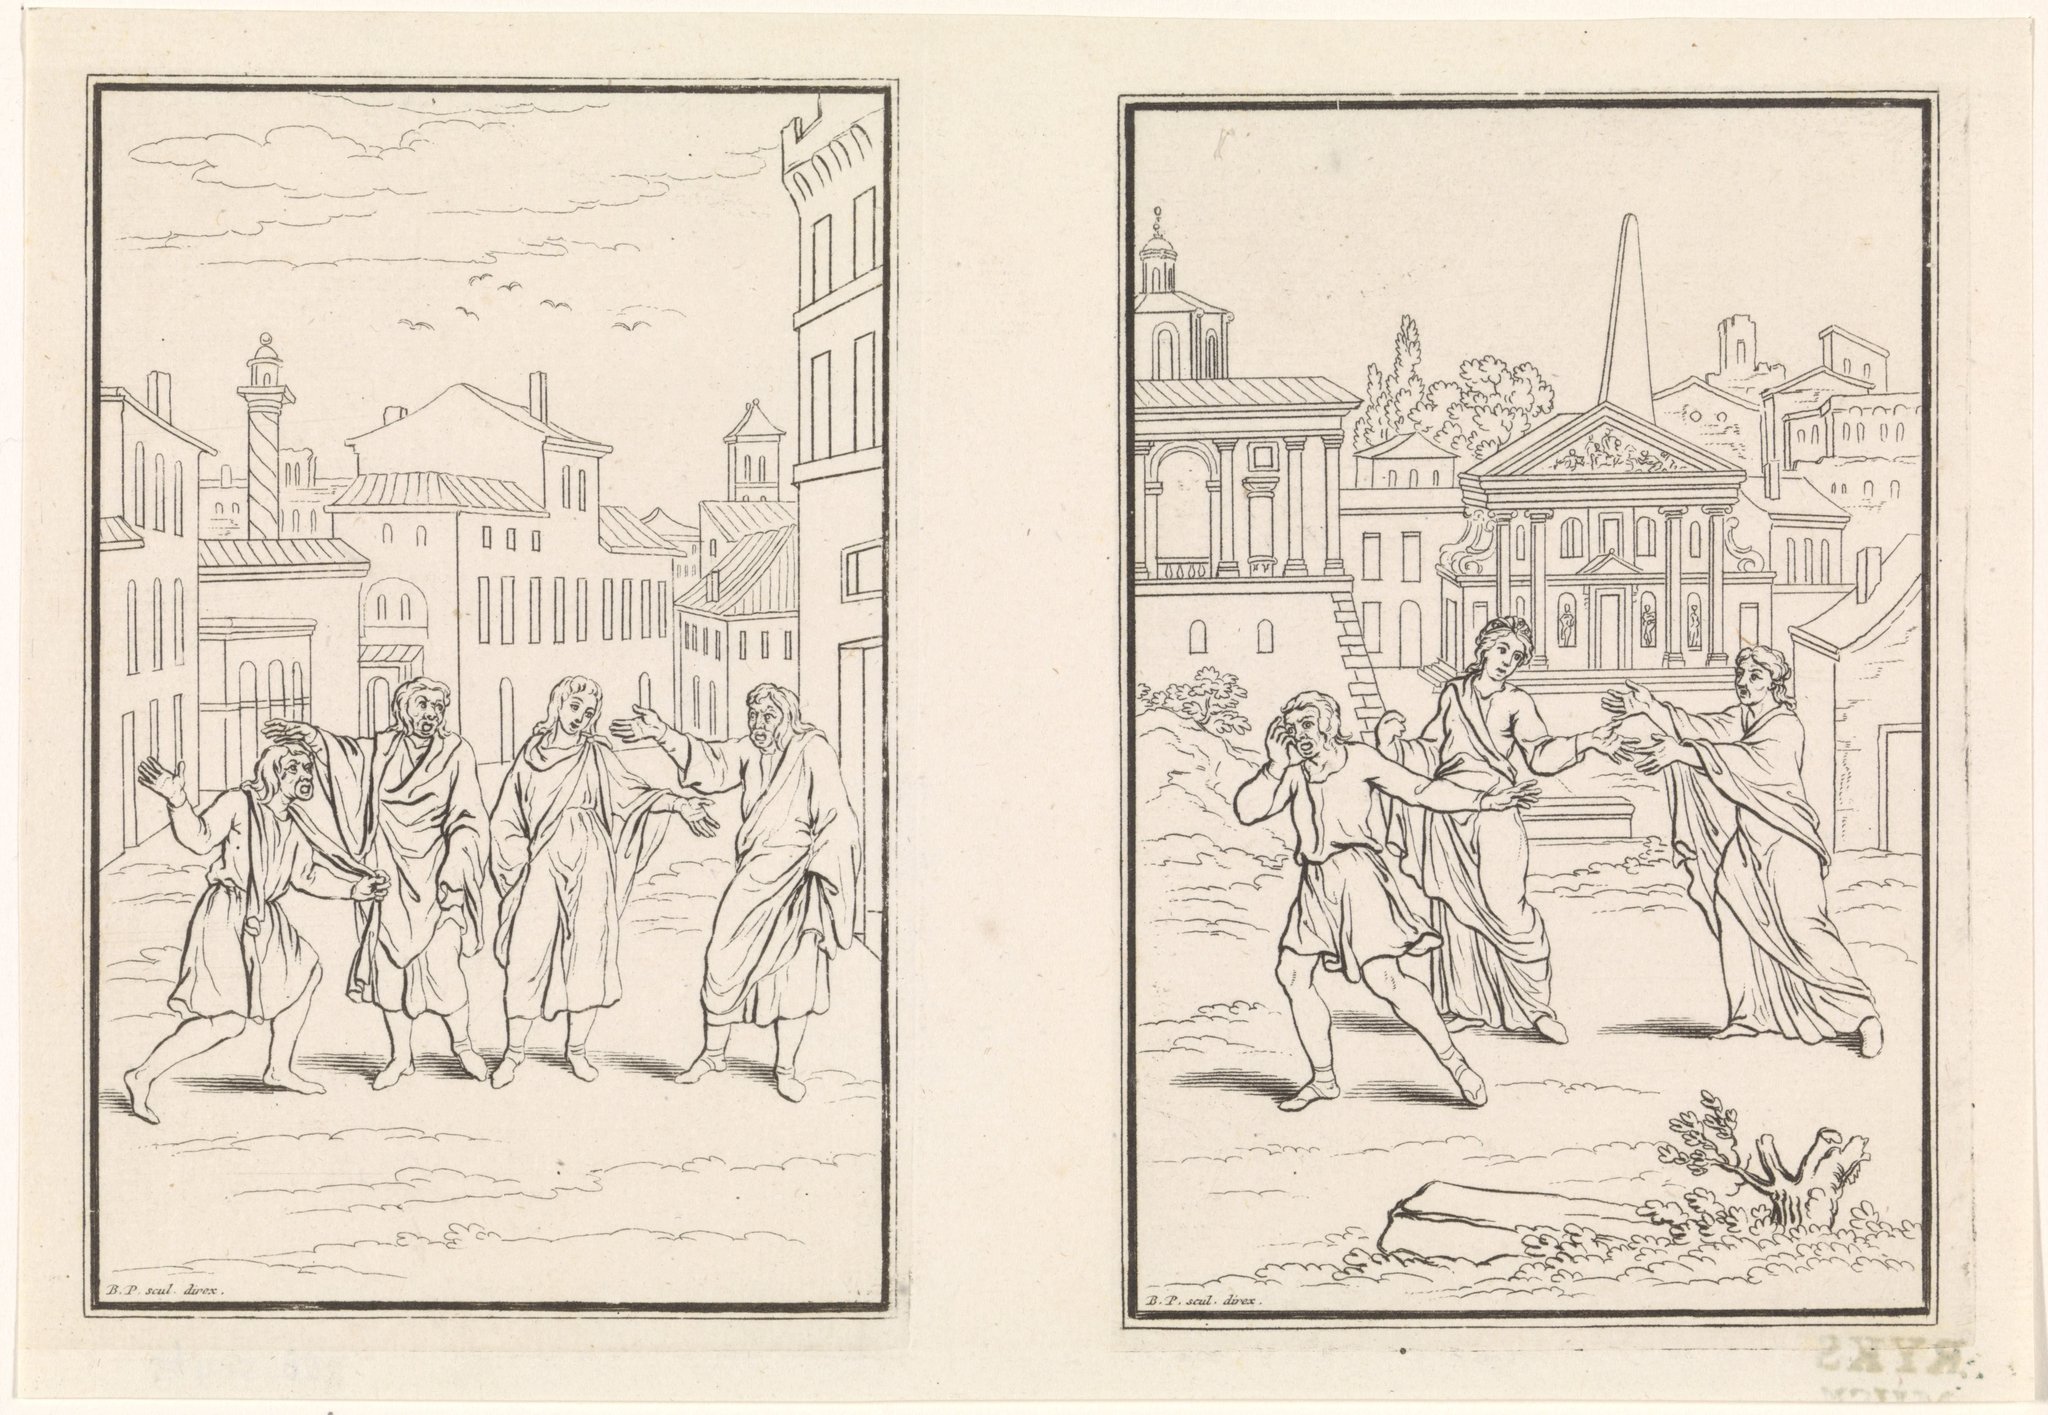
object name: print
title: Twee scènes uit de komedie Adelphoe van Terentius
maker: bernard picart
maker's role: draughtsman, print maker, publisher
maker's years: 1673-1733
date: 1716-1718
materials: paper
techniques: engraving, etching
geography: amsterdam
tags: specific works of literature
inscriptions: collector's mark: Lugt 2165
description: Definitieve staat van deze prenten ook gebruikt als illustratie in: Terentius, Publius. Les comedies de Terence: avec la traduction et les remarques, deel II, na p. 474 en na p. 322. [Geannoteerd door] Anne Dacier. Rotterdam: Caspar Fritsch, 1717.